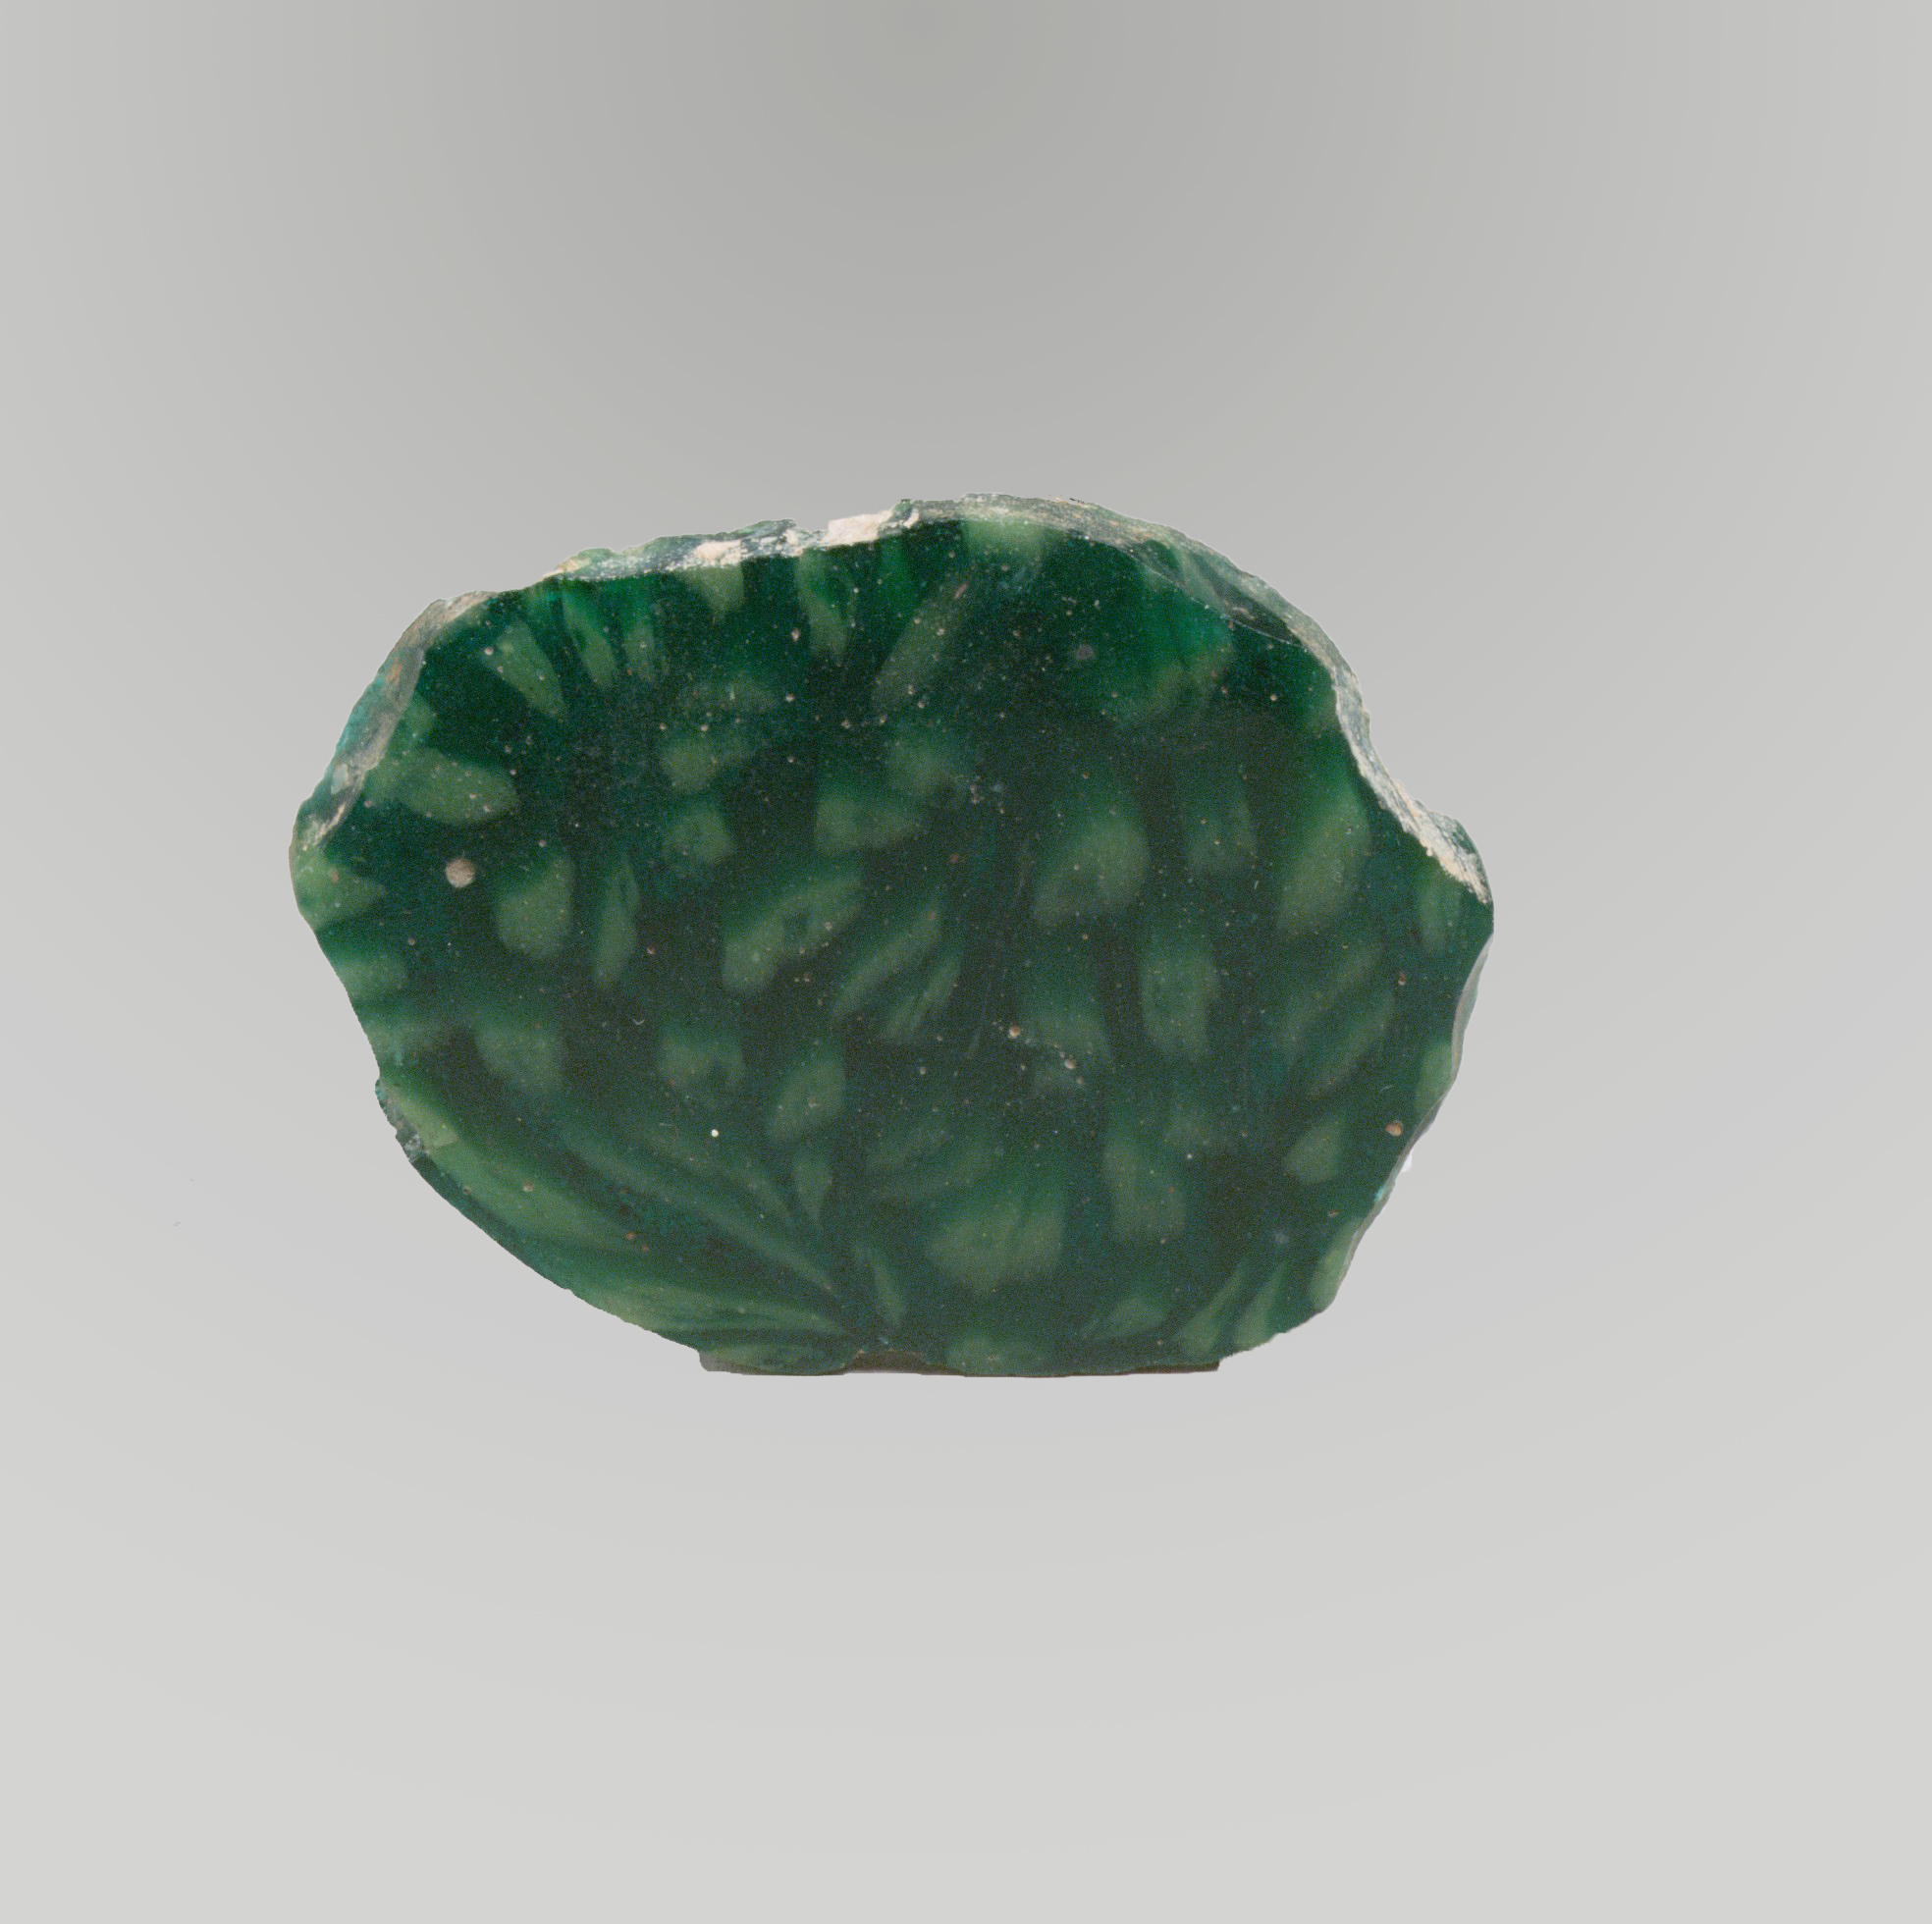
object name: fragment, mosaic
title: Glass mosaic inlay fragment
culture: roman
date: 34 BCE-33 CE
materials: glass